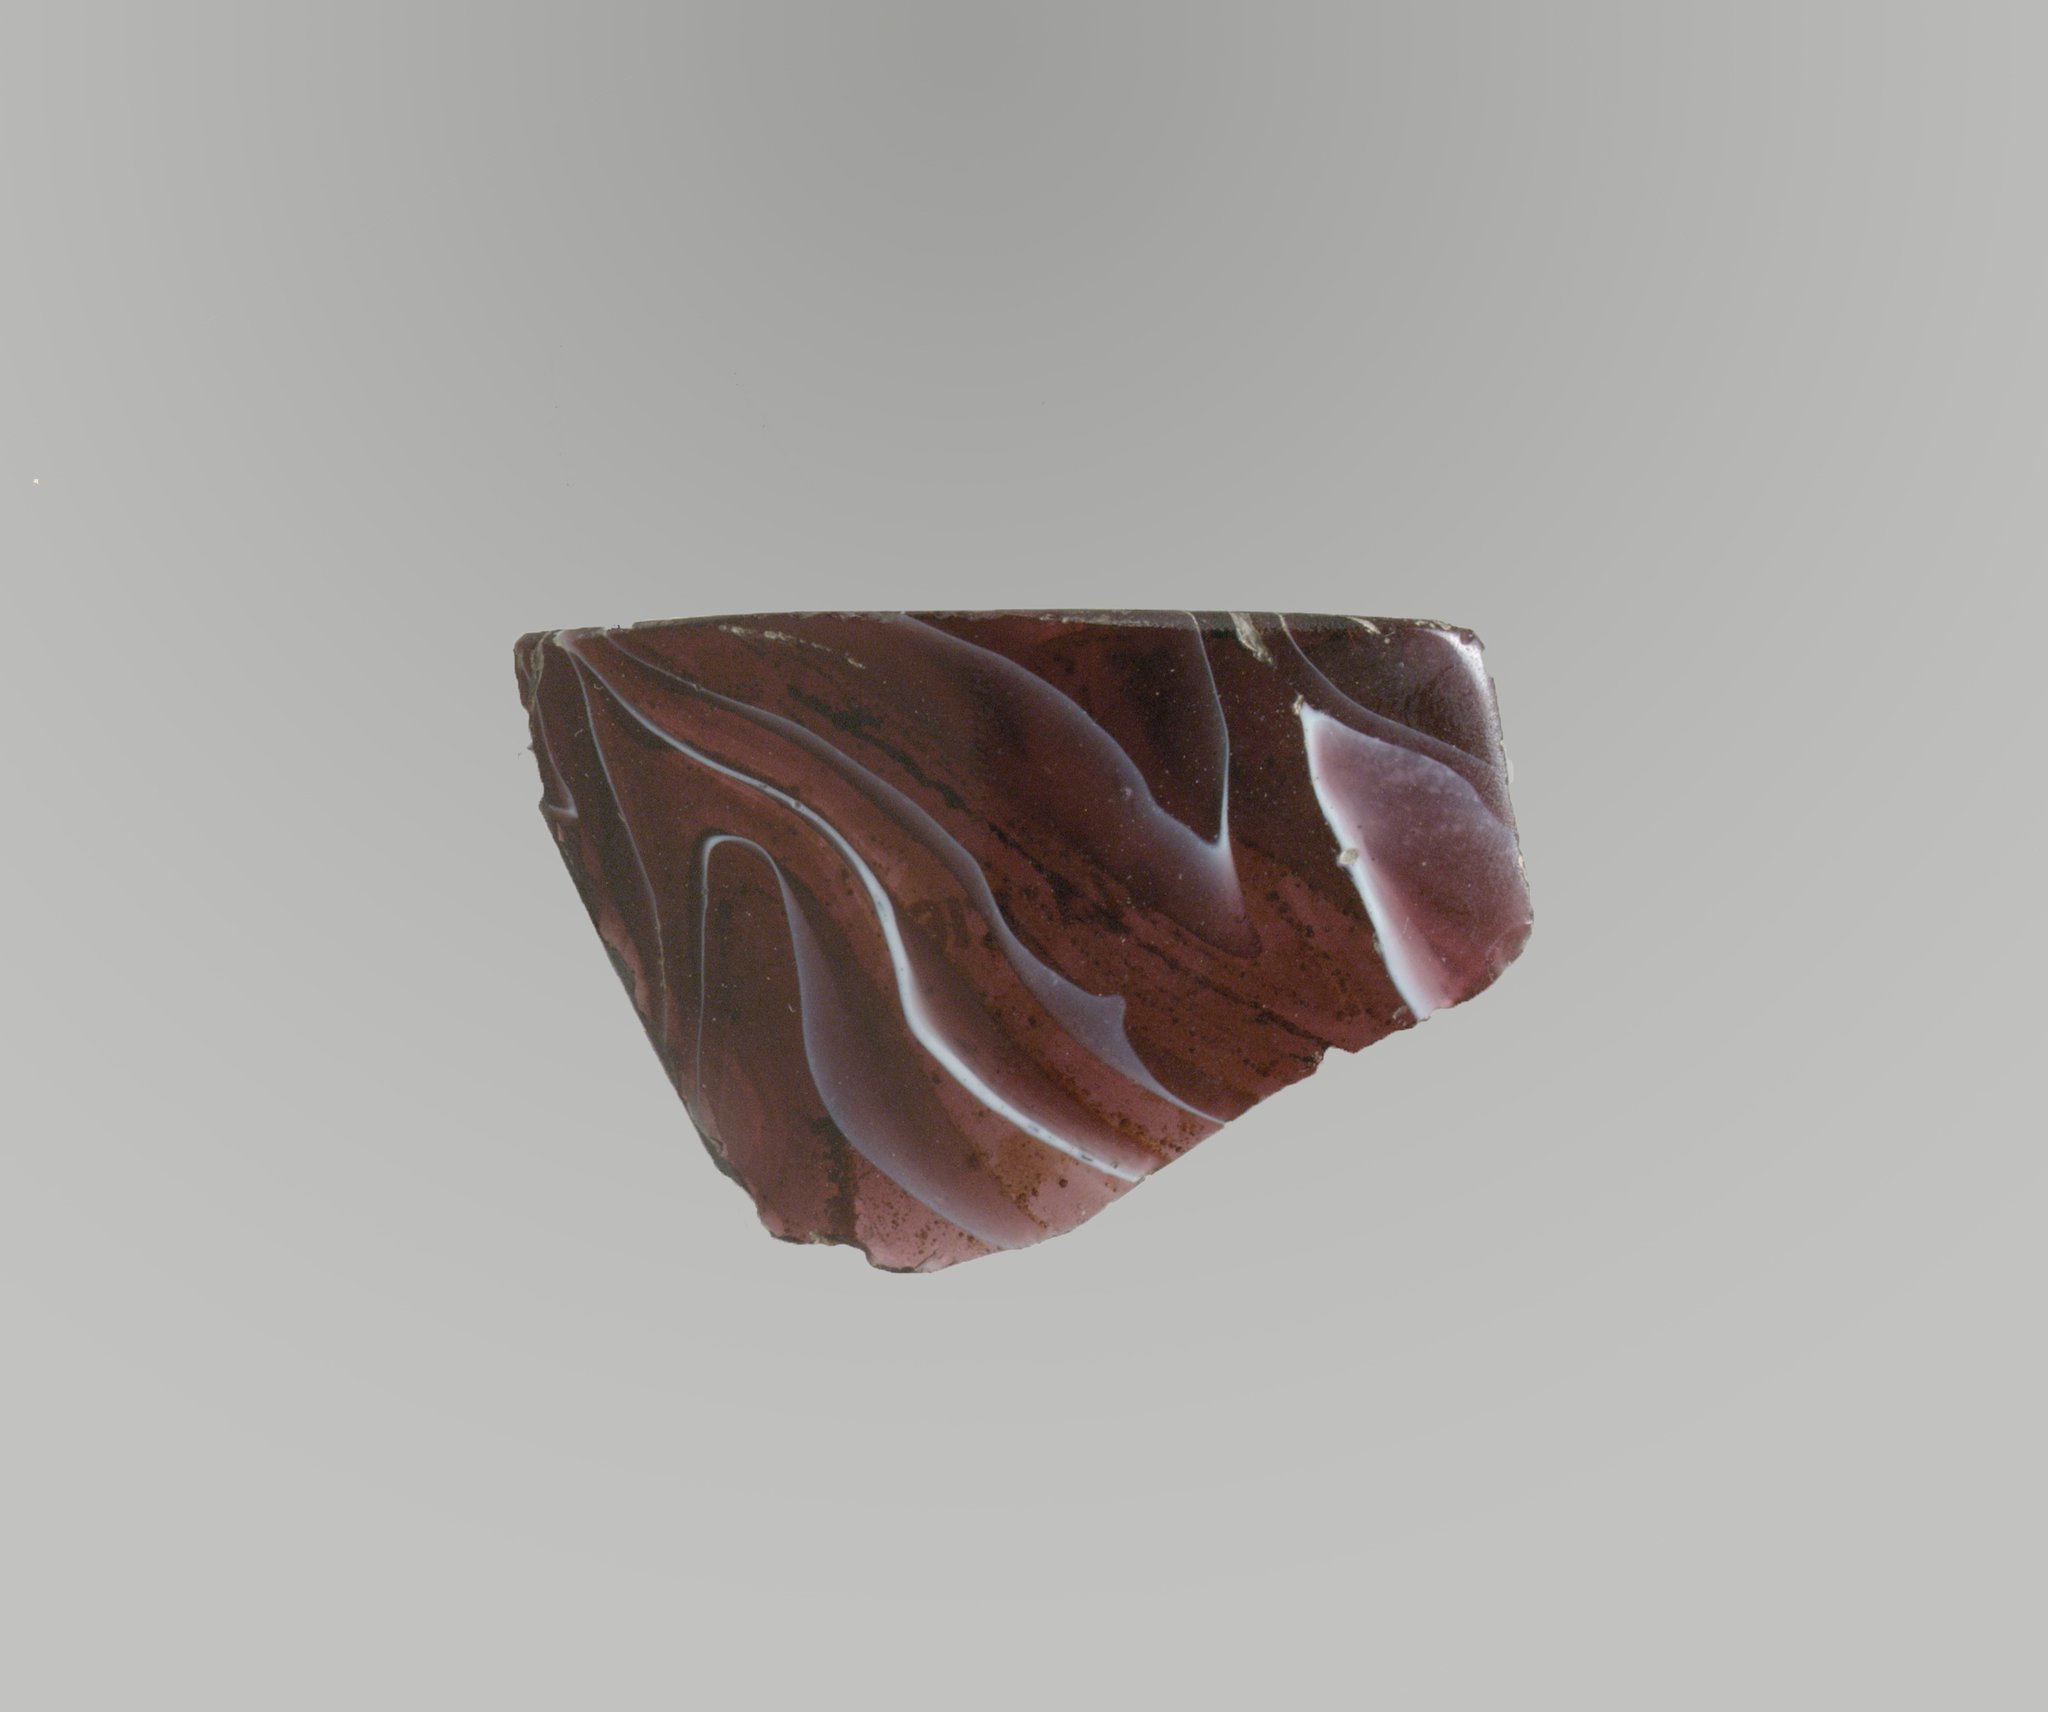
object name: fragment, mosaic beaker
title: Glass mosaic beaker fragment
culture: roman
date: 34 BCE-33 CE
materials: glass